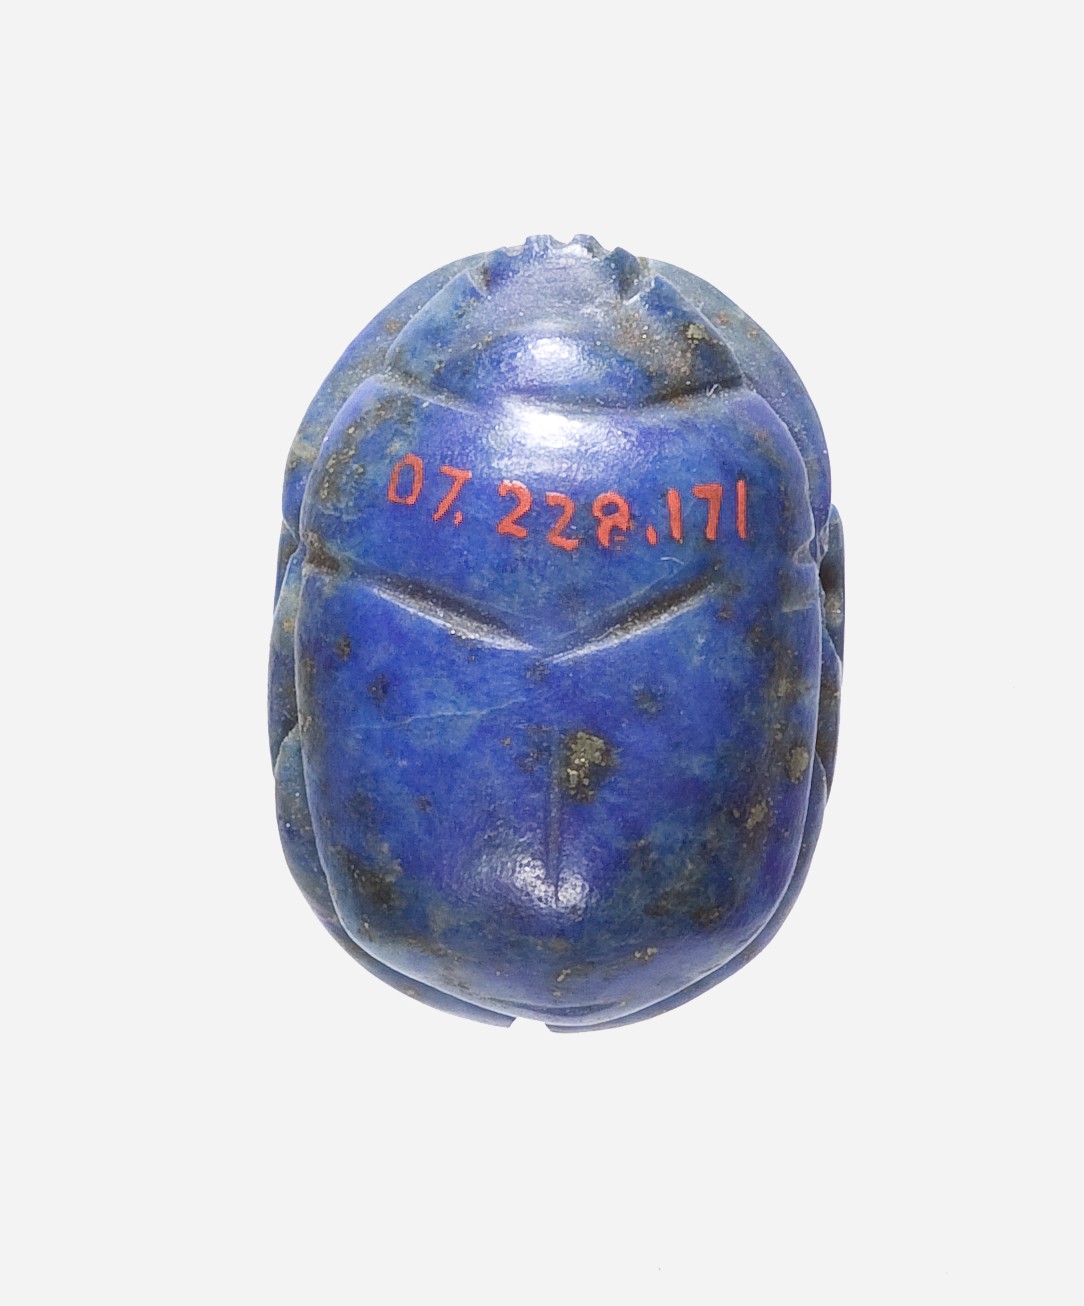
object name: scarab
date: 664-332 BCE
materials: lapis lazuli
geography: egypt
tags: scarabs